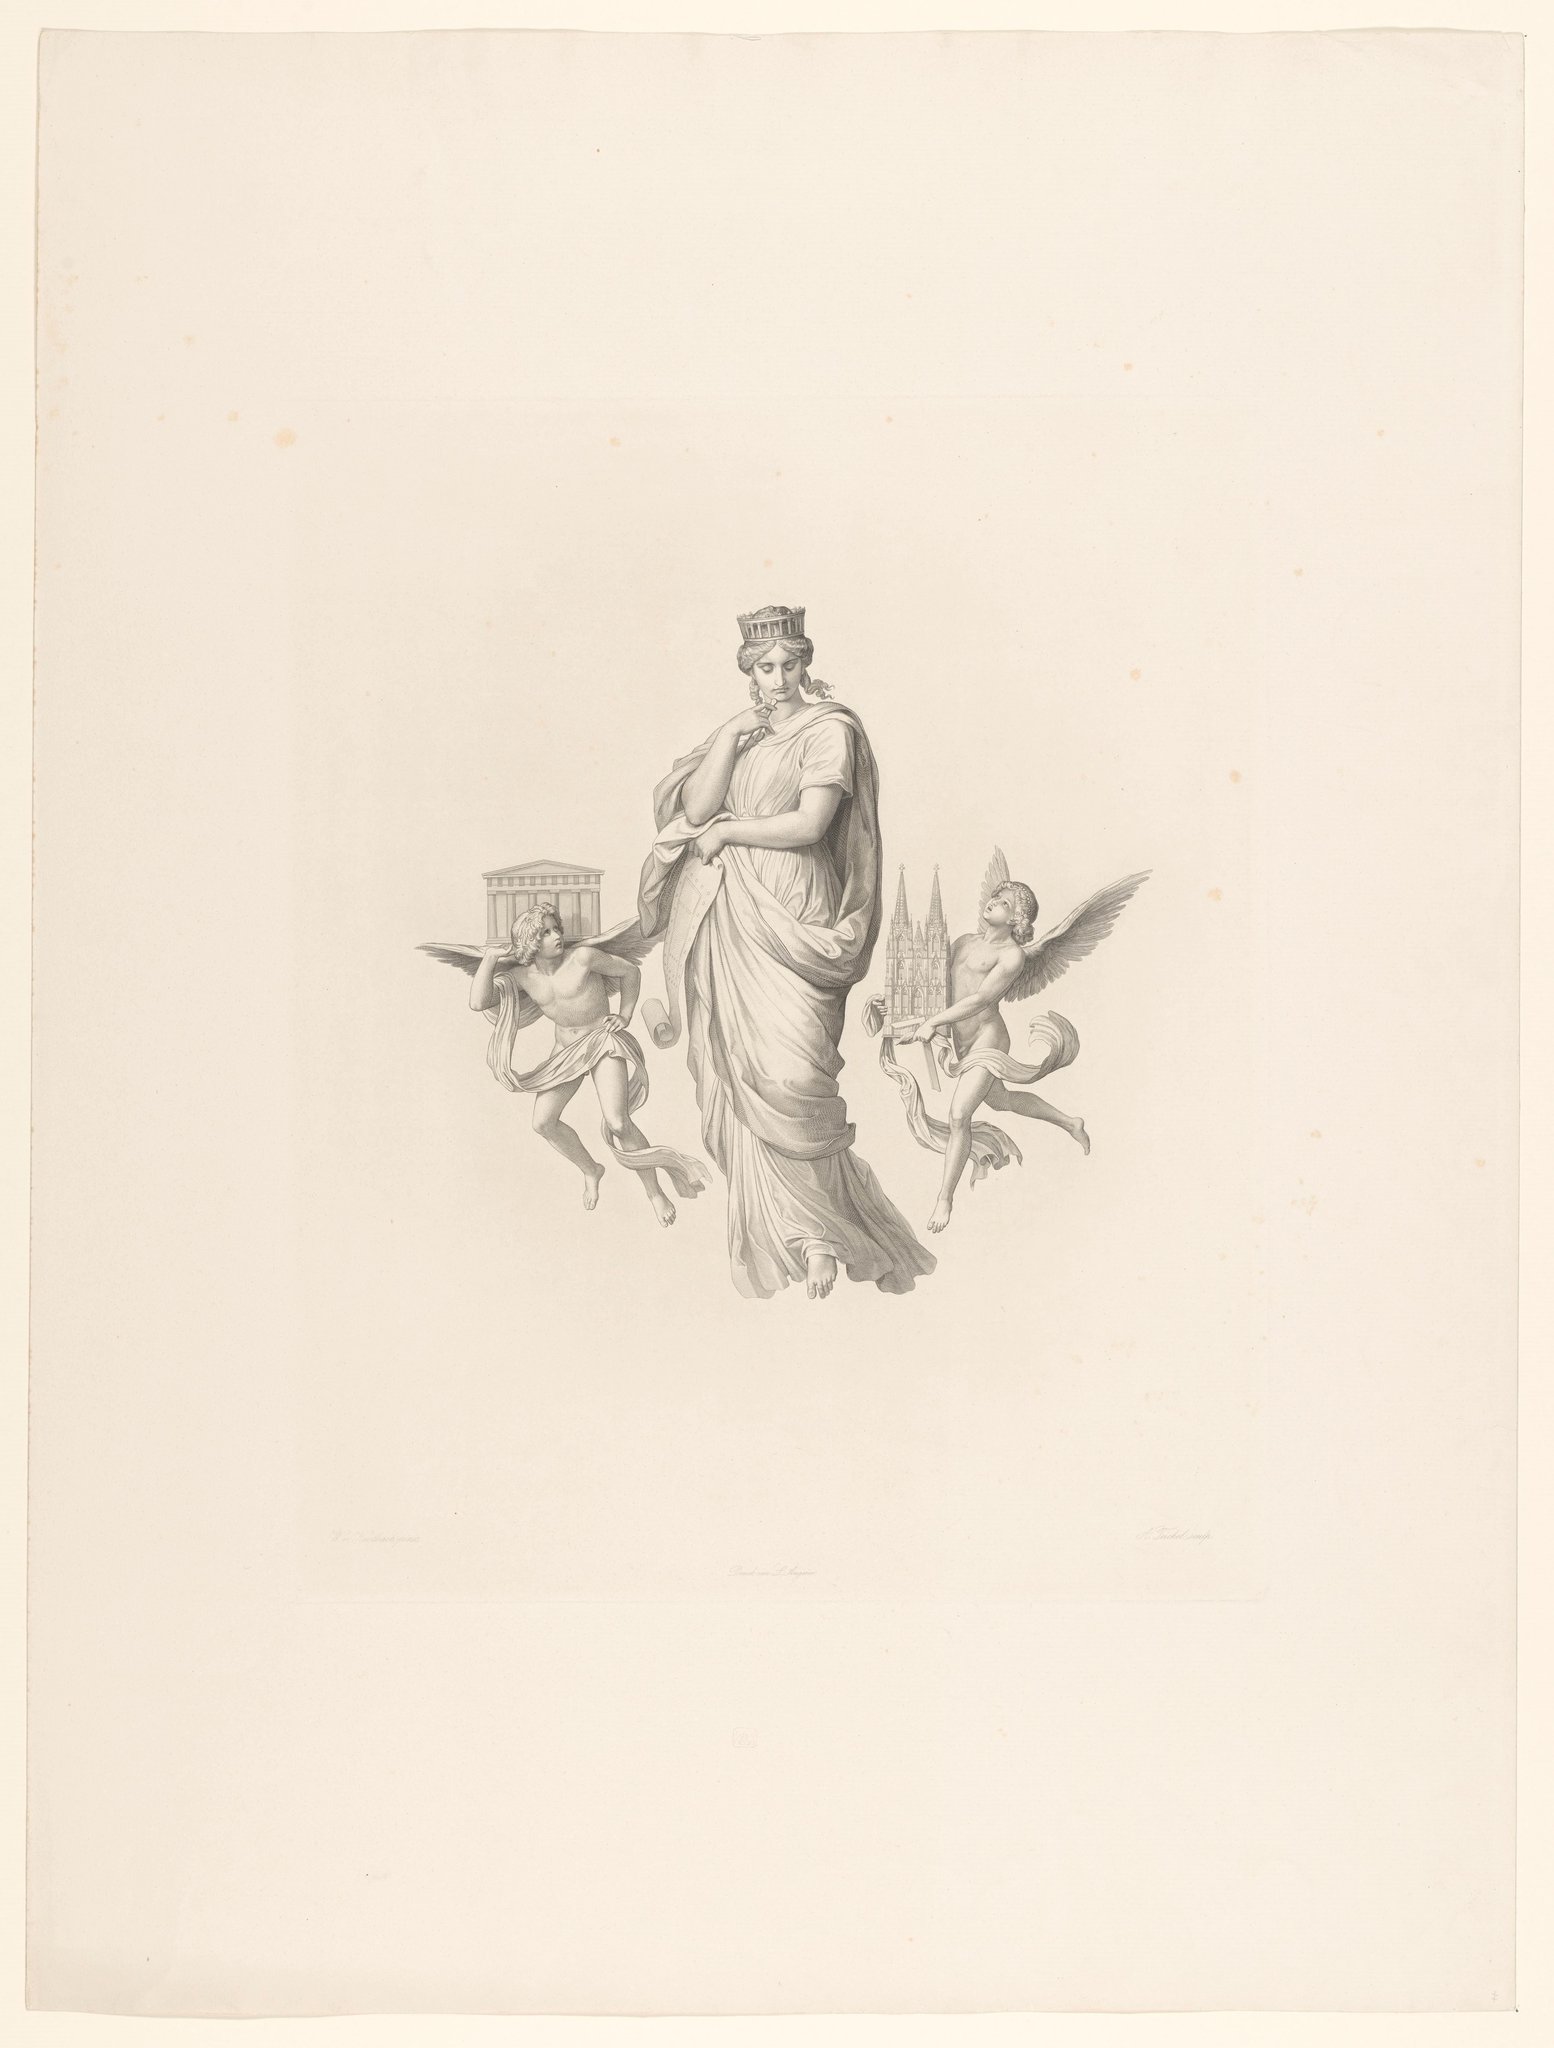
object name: print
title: Allegorie van de Architectuur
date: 1832-1873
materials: paper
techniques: engraving, etching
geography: germany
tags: 'architectura', symbolic representations, allegories and emblems ~ architecture; 'architettura' (ripa)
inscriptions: collector's mark: Lugt 2165